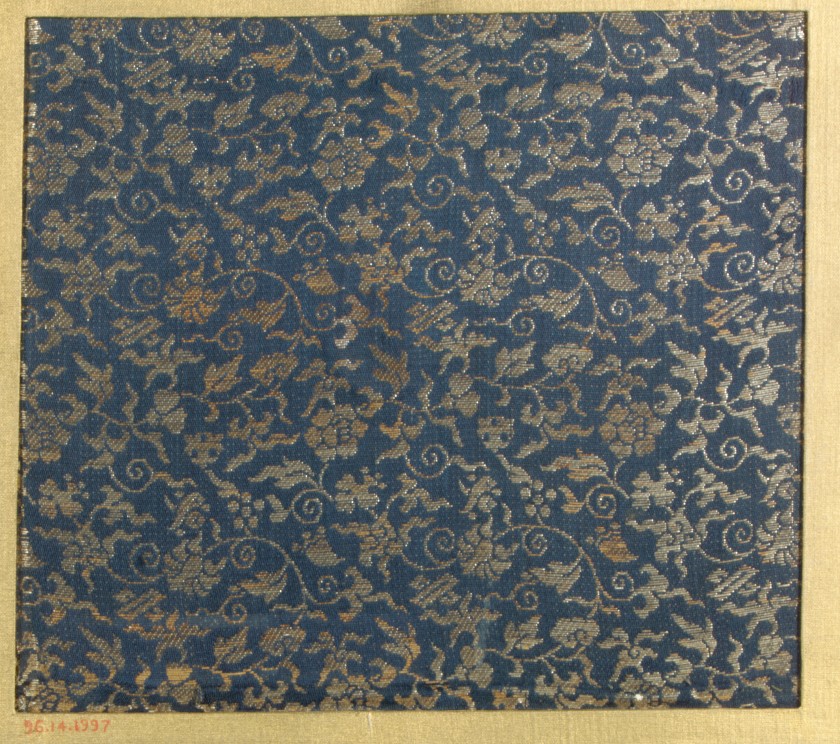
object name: piece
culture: japanese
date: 1701-1900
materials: silk